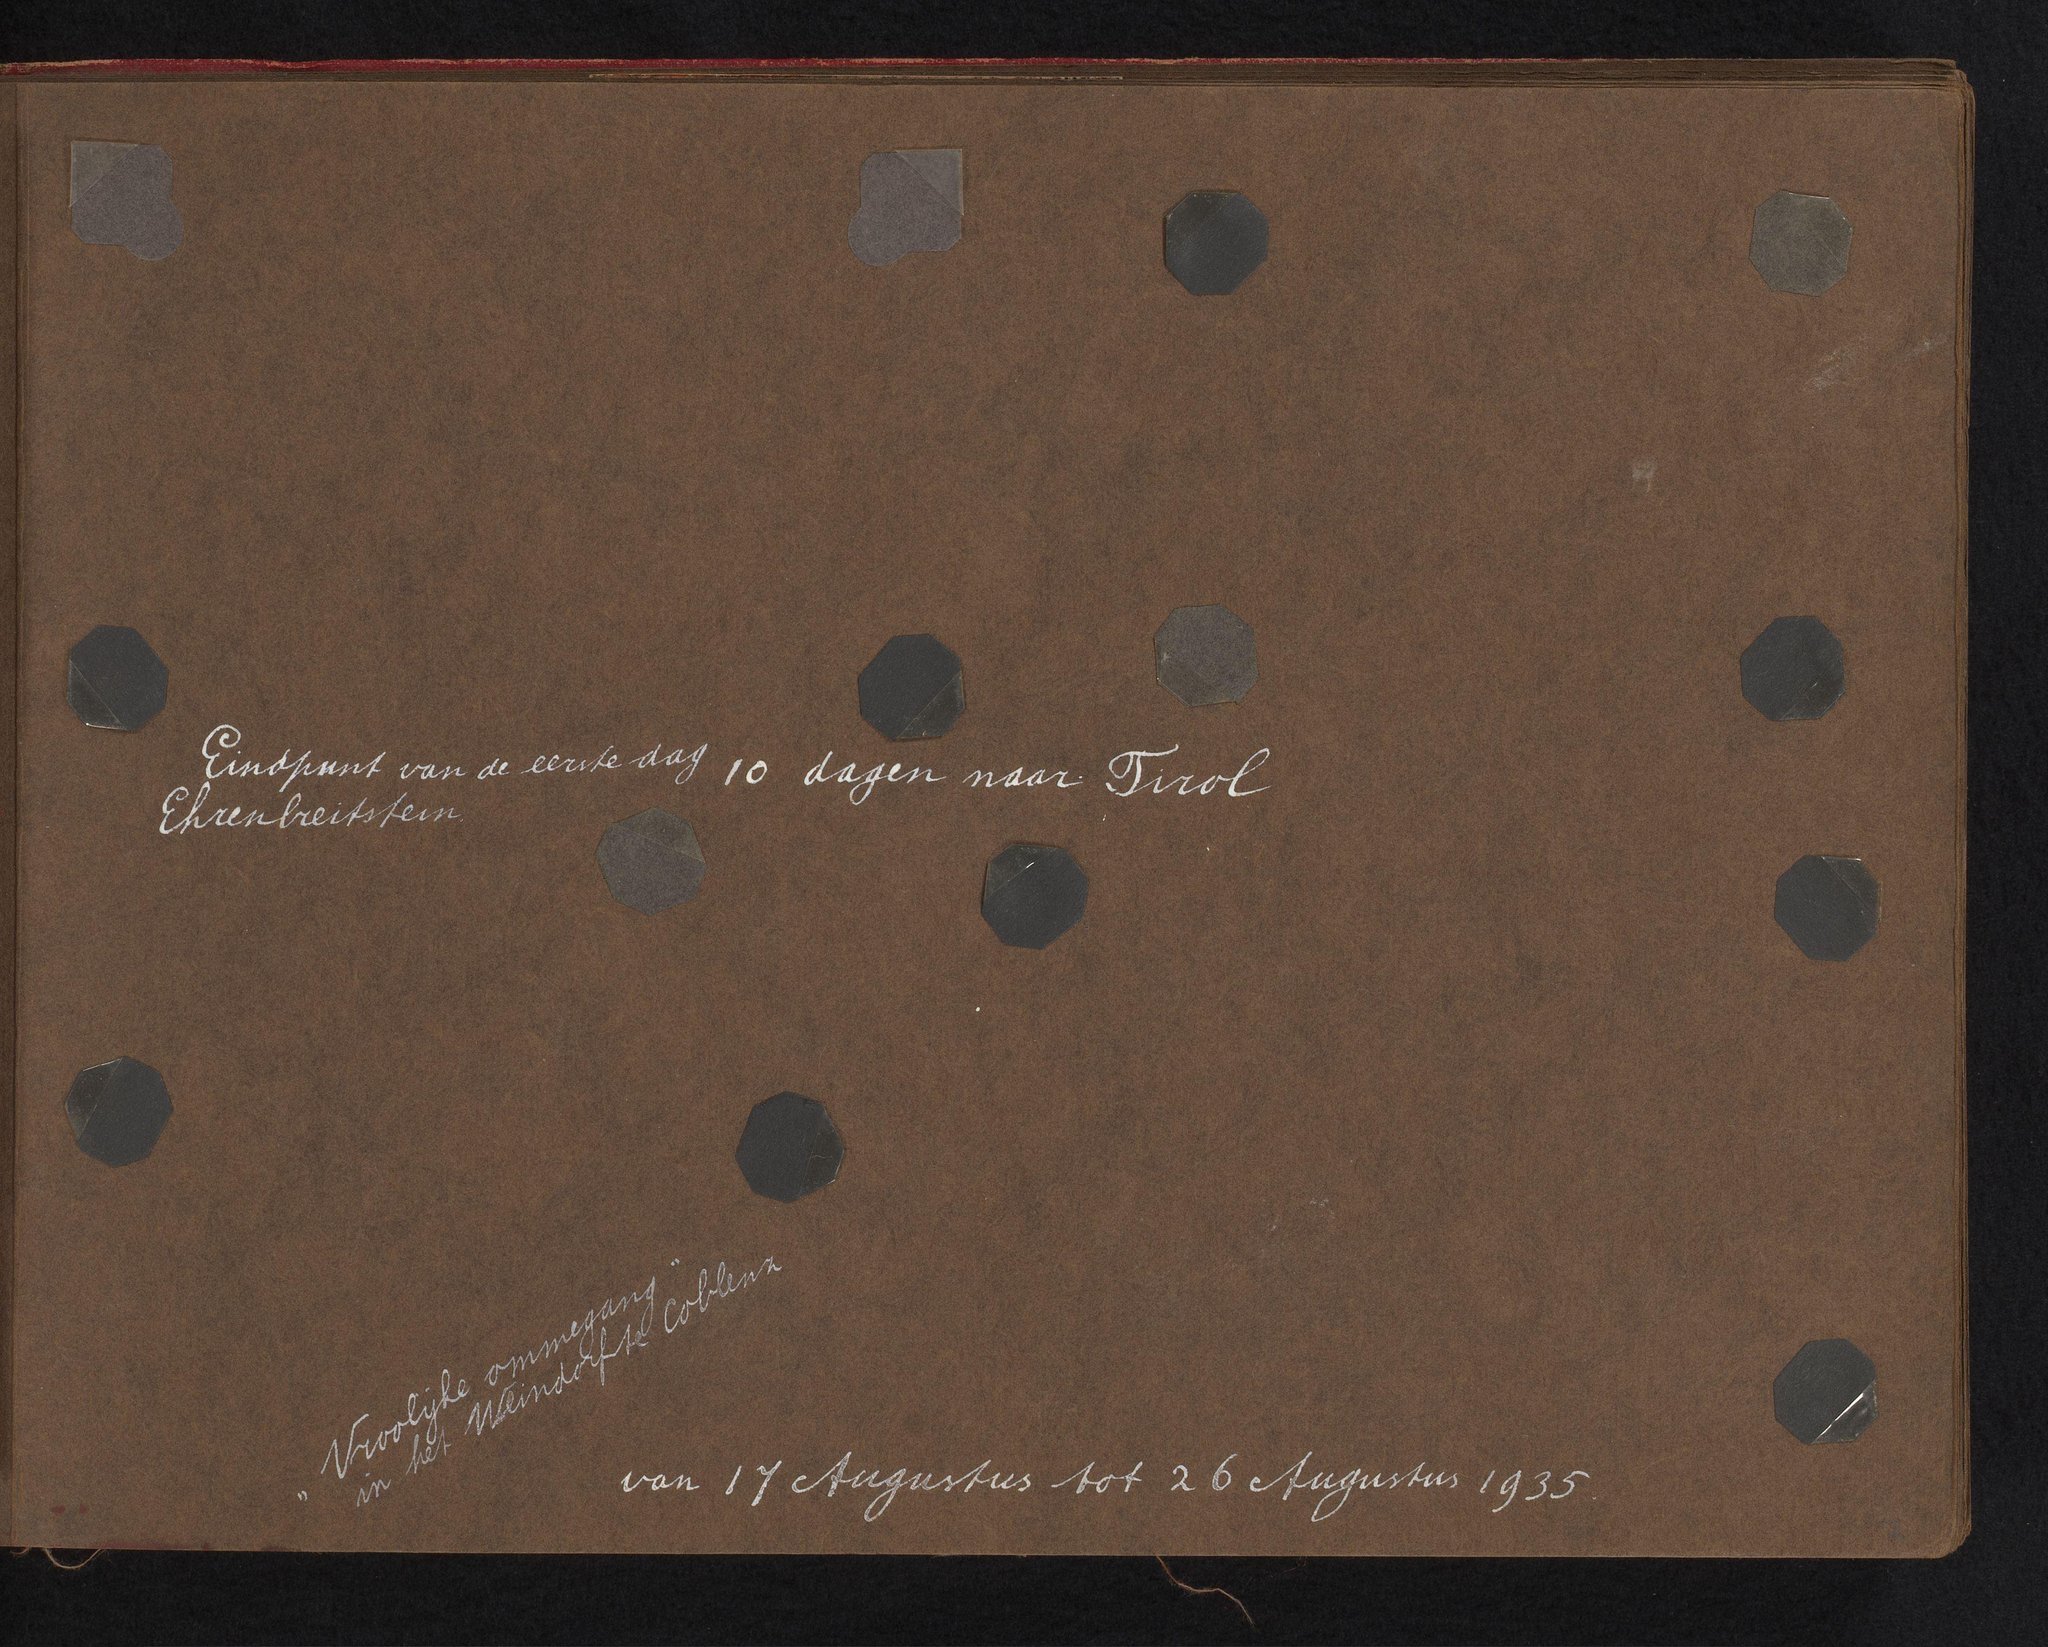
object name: album leaf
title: Leeg albumblad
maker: Anonymous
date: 1935-1937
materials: ink, paper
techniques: pen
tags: germany, austria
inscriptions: inscription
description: Leeg albumblad waarop vier foto's hebben gezeten van de reis naar Tirol in augustus 1935. Onderdeel van het reisalbum van de familie Van den Broek 1935-1937.